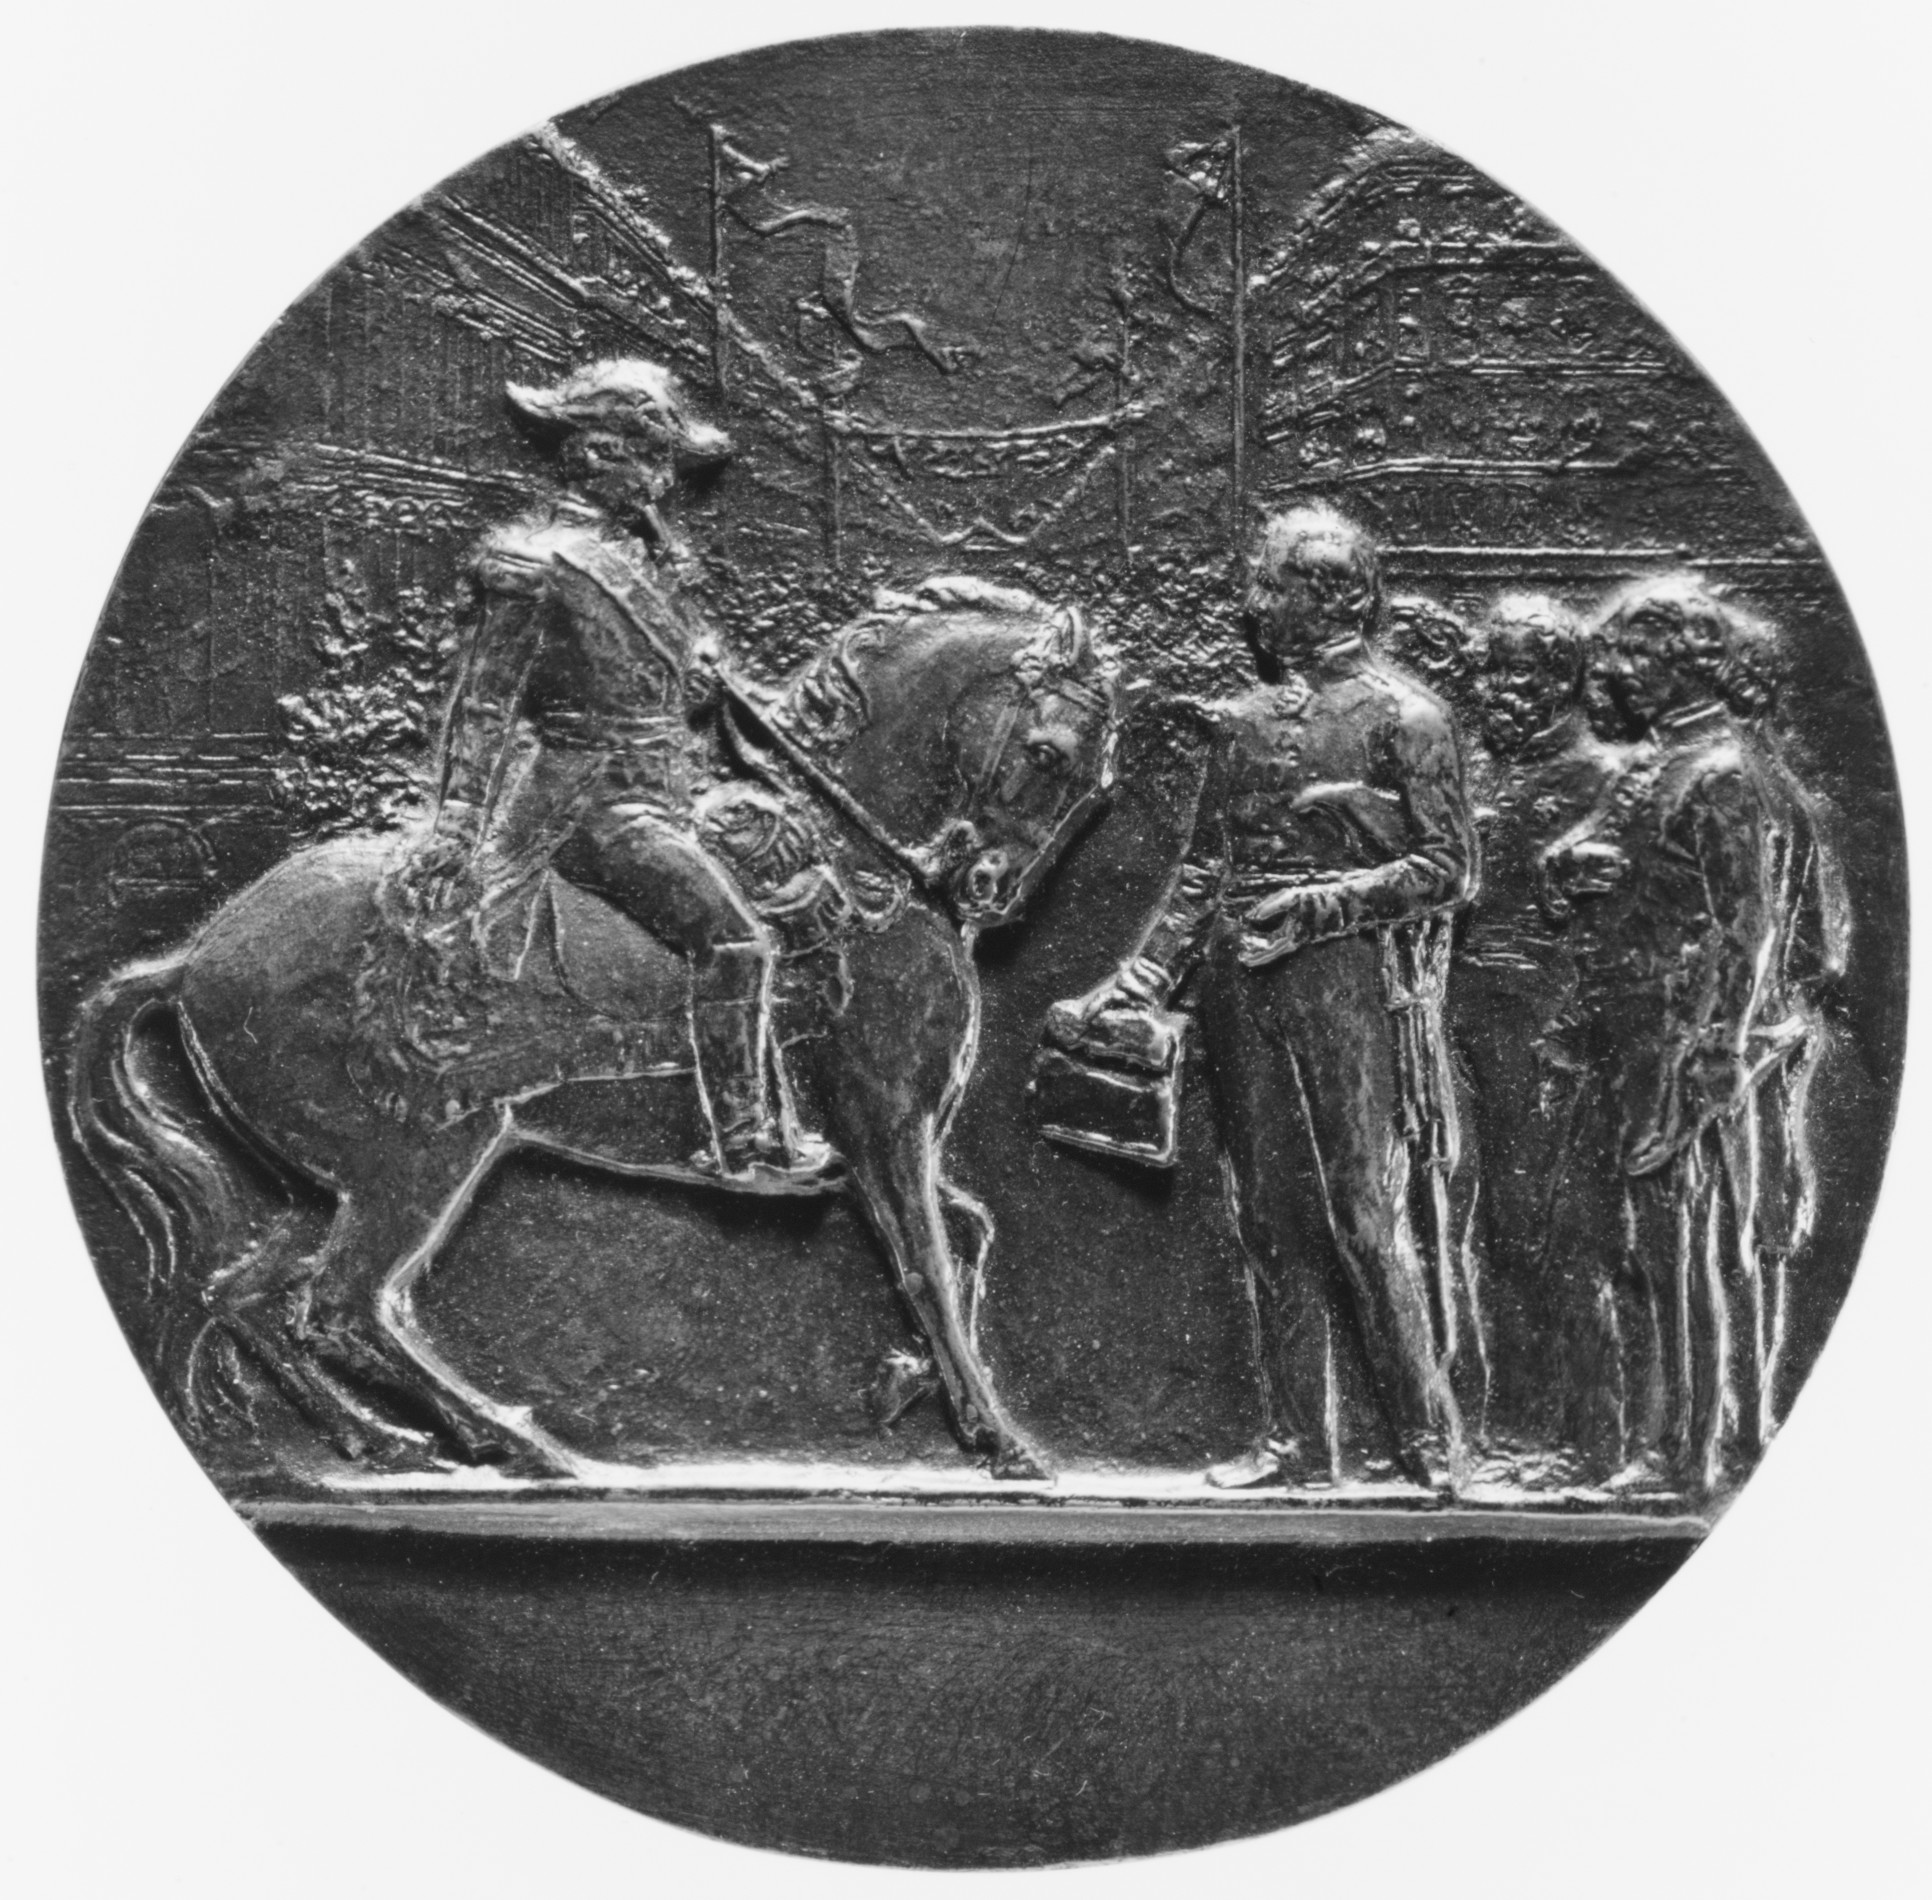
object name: medal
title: Napoleon III on Horseback, Inaugurating the Boulevard de Strasbourg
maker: françois-joseph-hubert ponscarme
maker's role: artist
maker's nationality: french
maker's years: 1827-1903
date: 1866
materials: bronze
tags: napoleon iii,men,horses